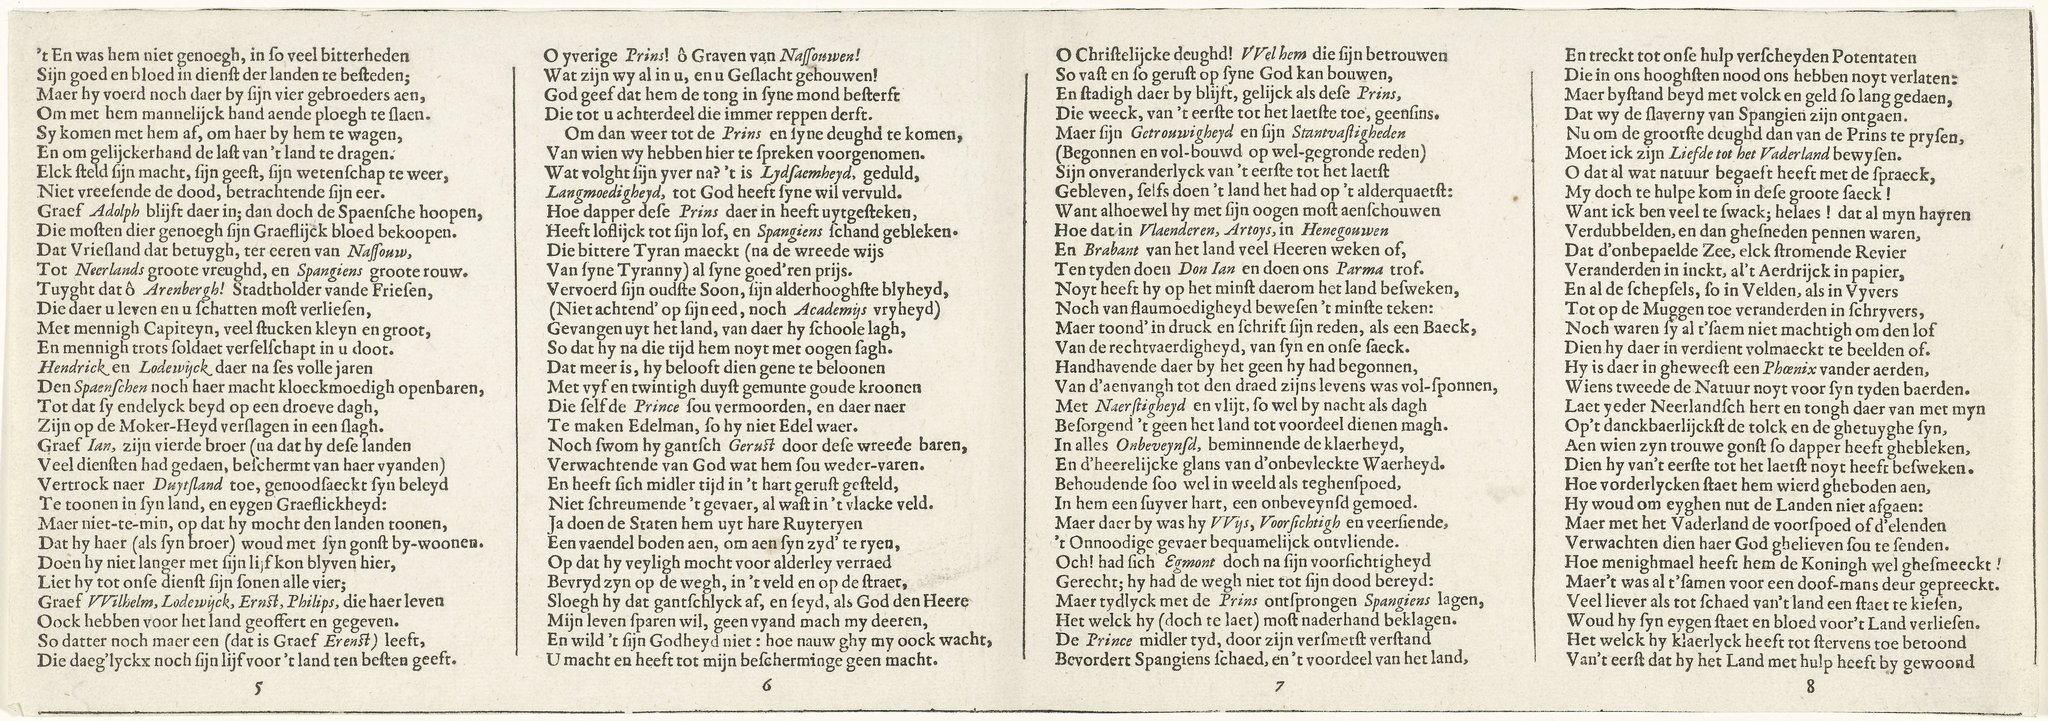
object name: text sheet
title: Currus triumphalis Illustris / Triomftocht van Willem van Oranje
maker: jan jansz starter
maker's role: publisher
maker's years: 1593-1626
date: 1626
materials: paper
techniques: letterpress printing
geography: northern netherlands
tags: delft, william i (prince of orange)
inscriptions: date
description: Tekstblad met de kolommen 5-8 behorend bij de zinnebeeldige voorstelling van de deugden van Prins Willem van Oranje.